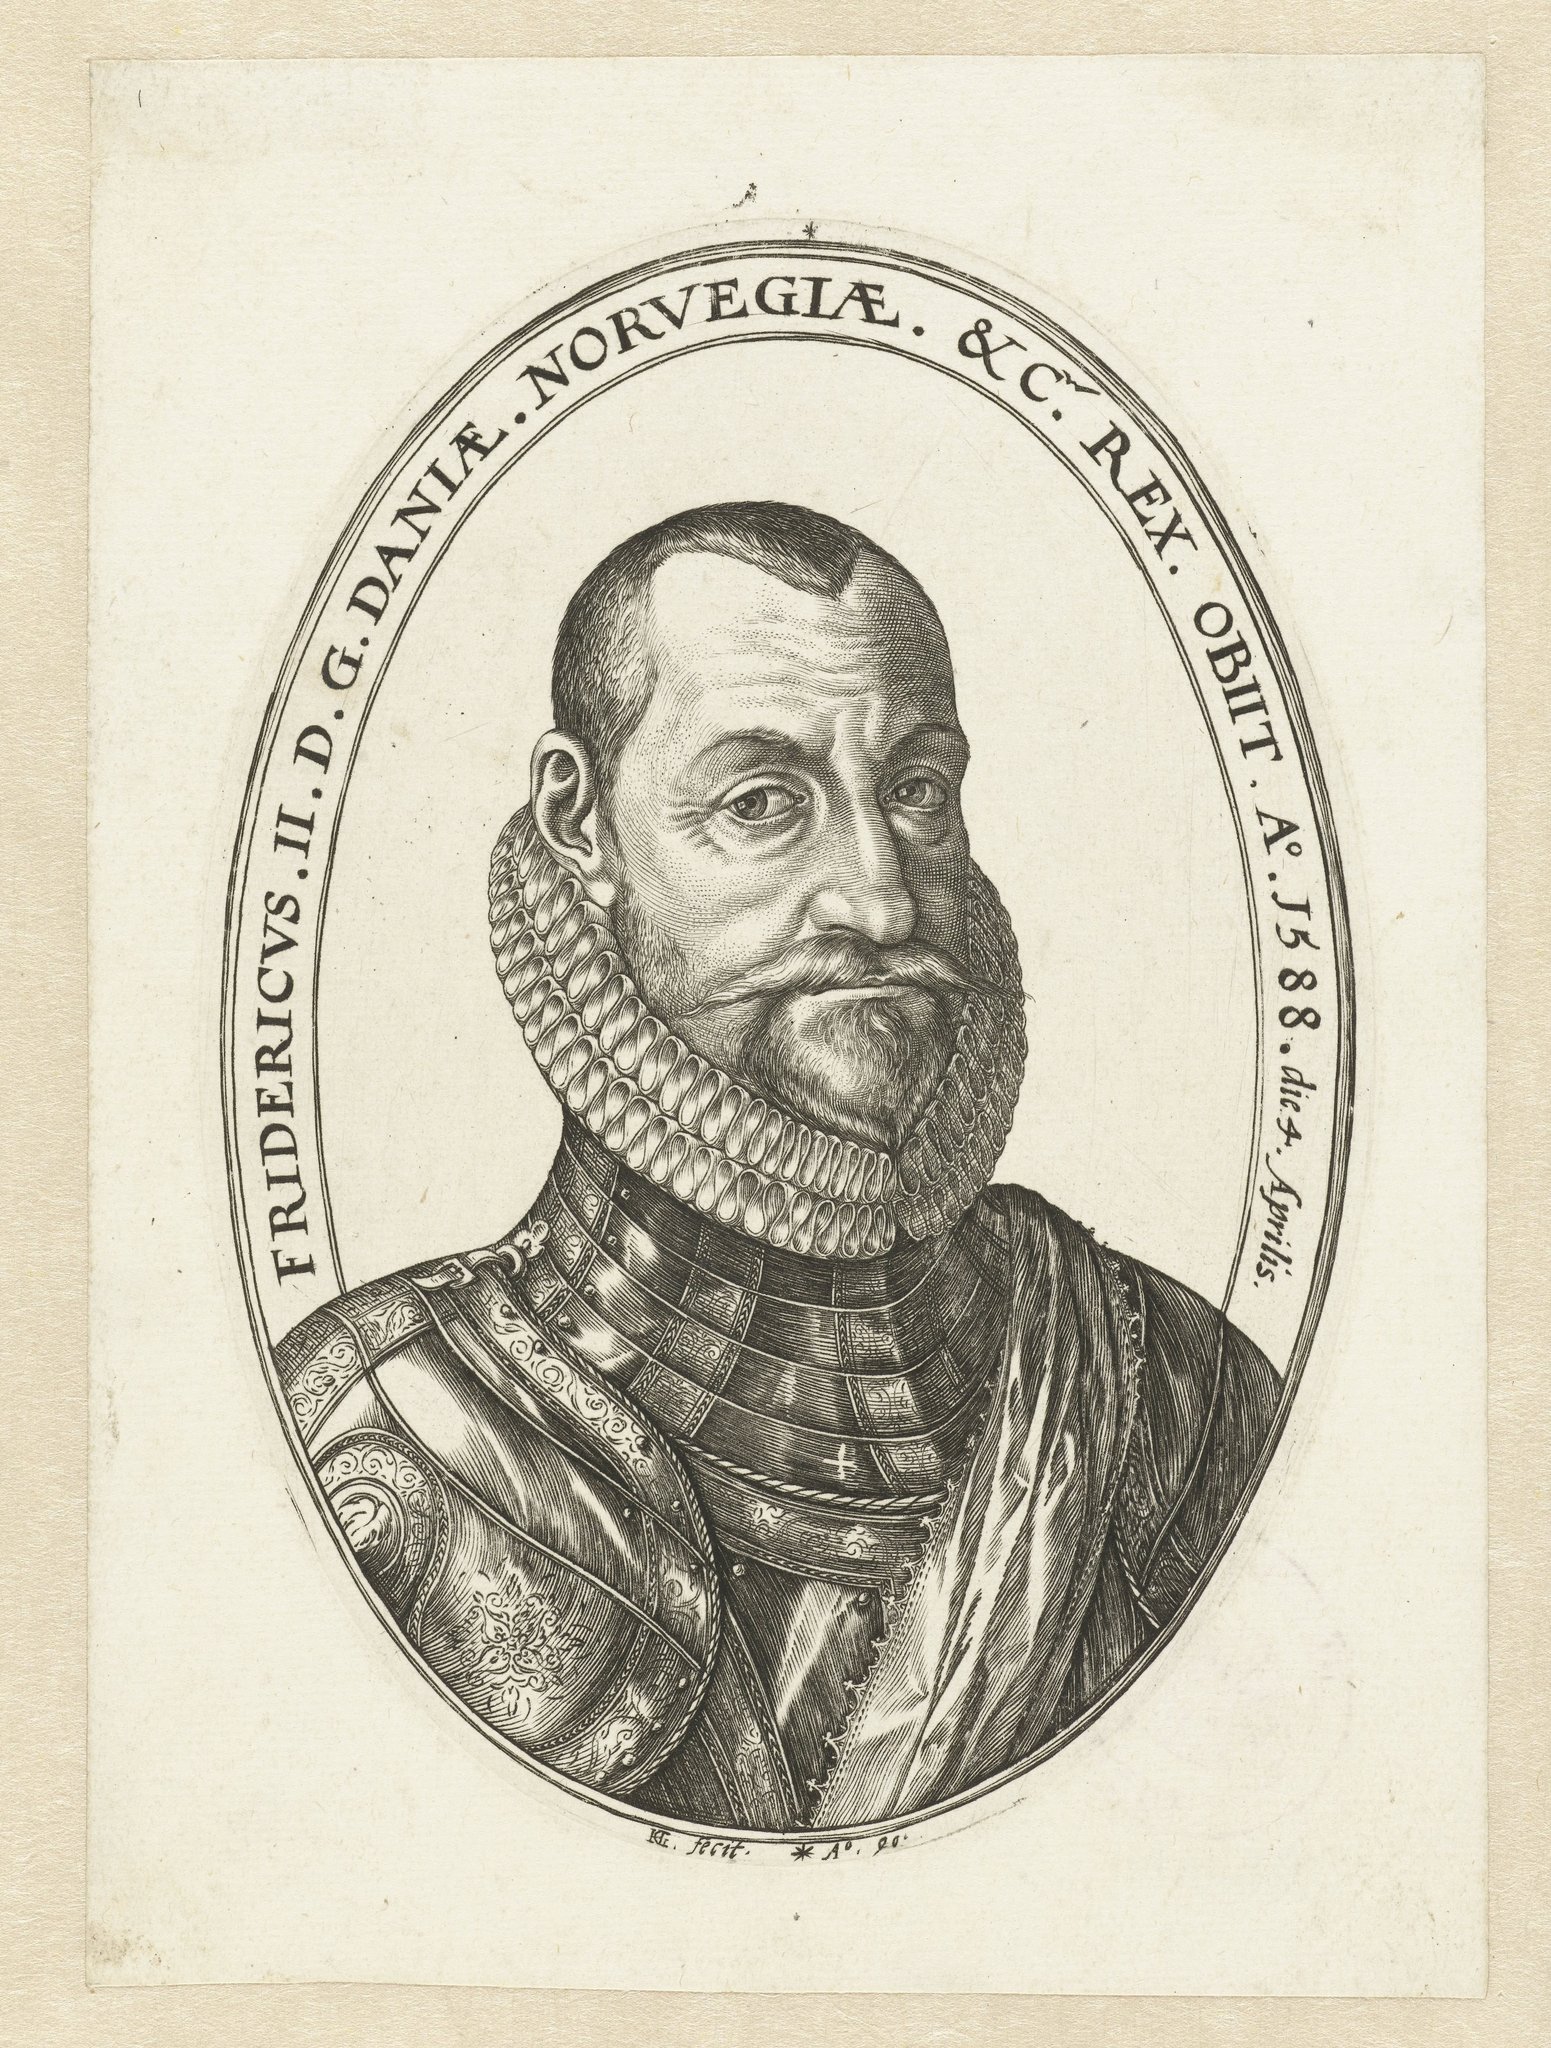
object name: print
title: Portret van Frederik II, Koning van Denemarken en Noorwegen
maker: hendrick goltzius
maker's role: draughtsman, painter, print maker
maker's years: 1558-1617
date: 1590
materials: paper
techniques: engraving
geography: haarlem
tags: frederik ii (koning van denemarken en noorwegen), historical persons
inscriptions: signature and date: ‘HG. fecit. * Ao. 90'’, collector's mark: Lugt 240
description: Buste van Frederik II in een harnas. In een ovaal, lege achtergrond. Langs de bovenkant van het ovaal een marge met hierin een tekst in Latijn.